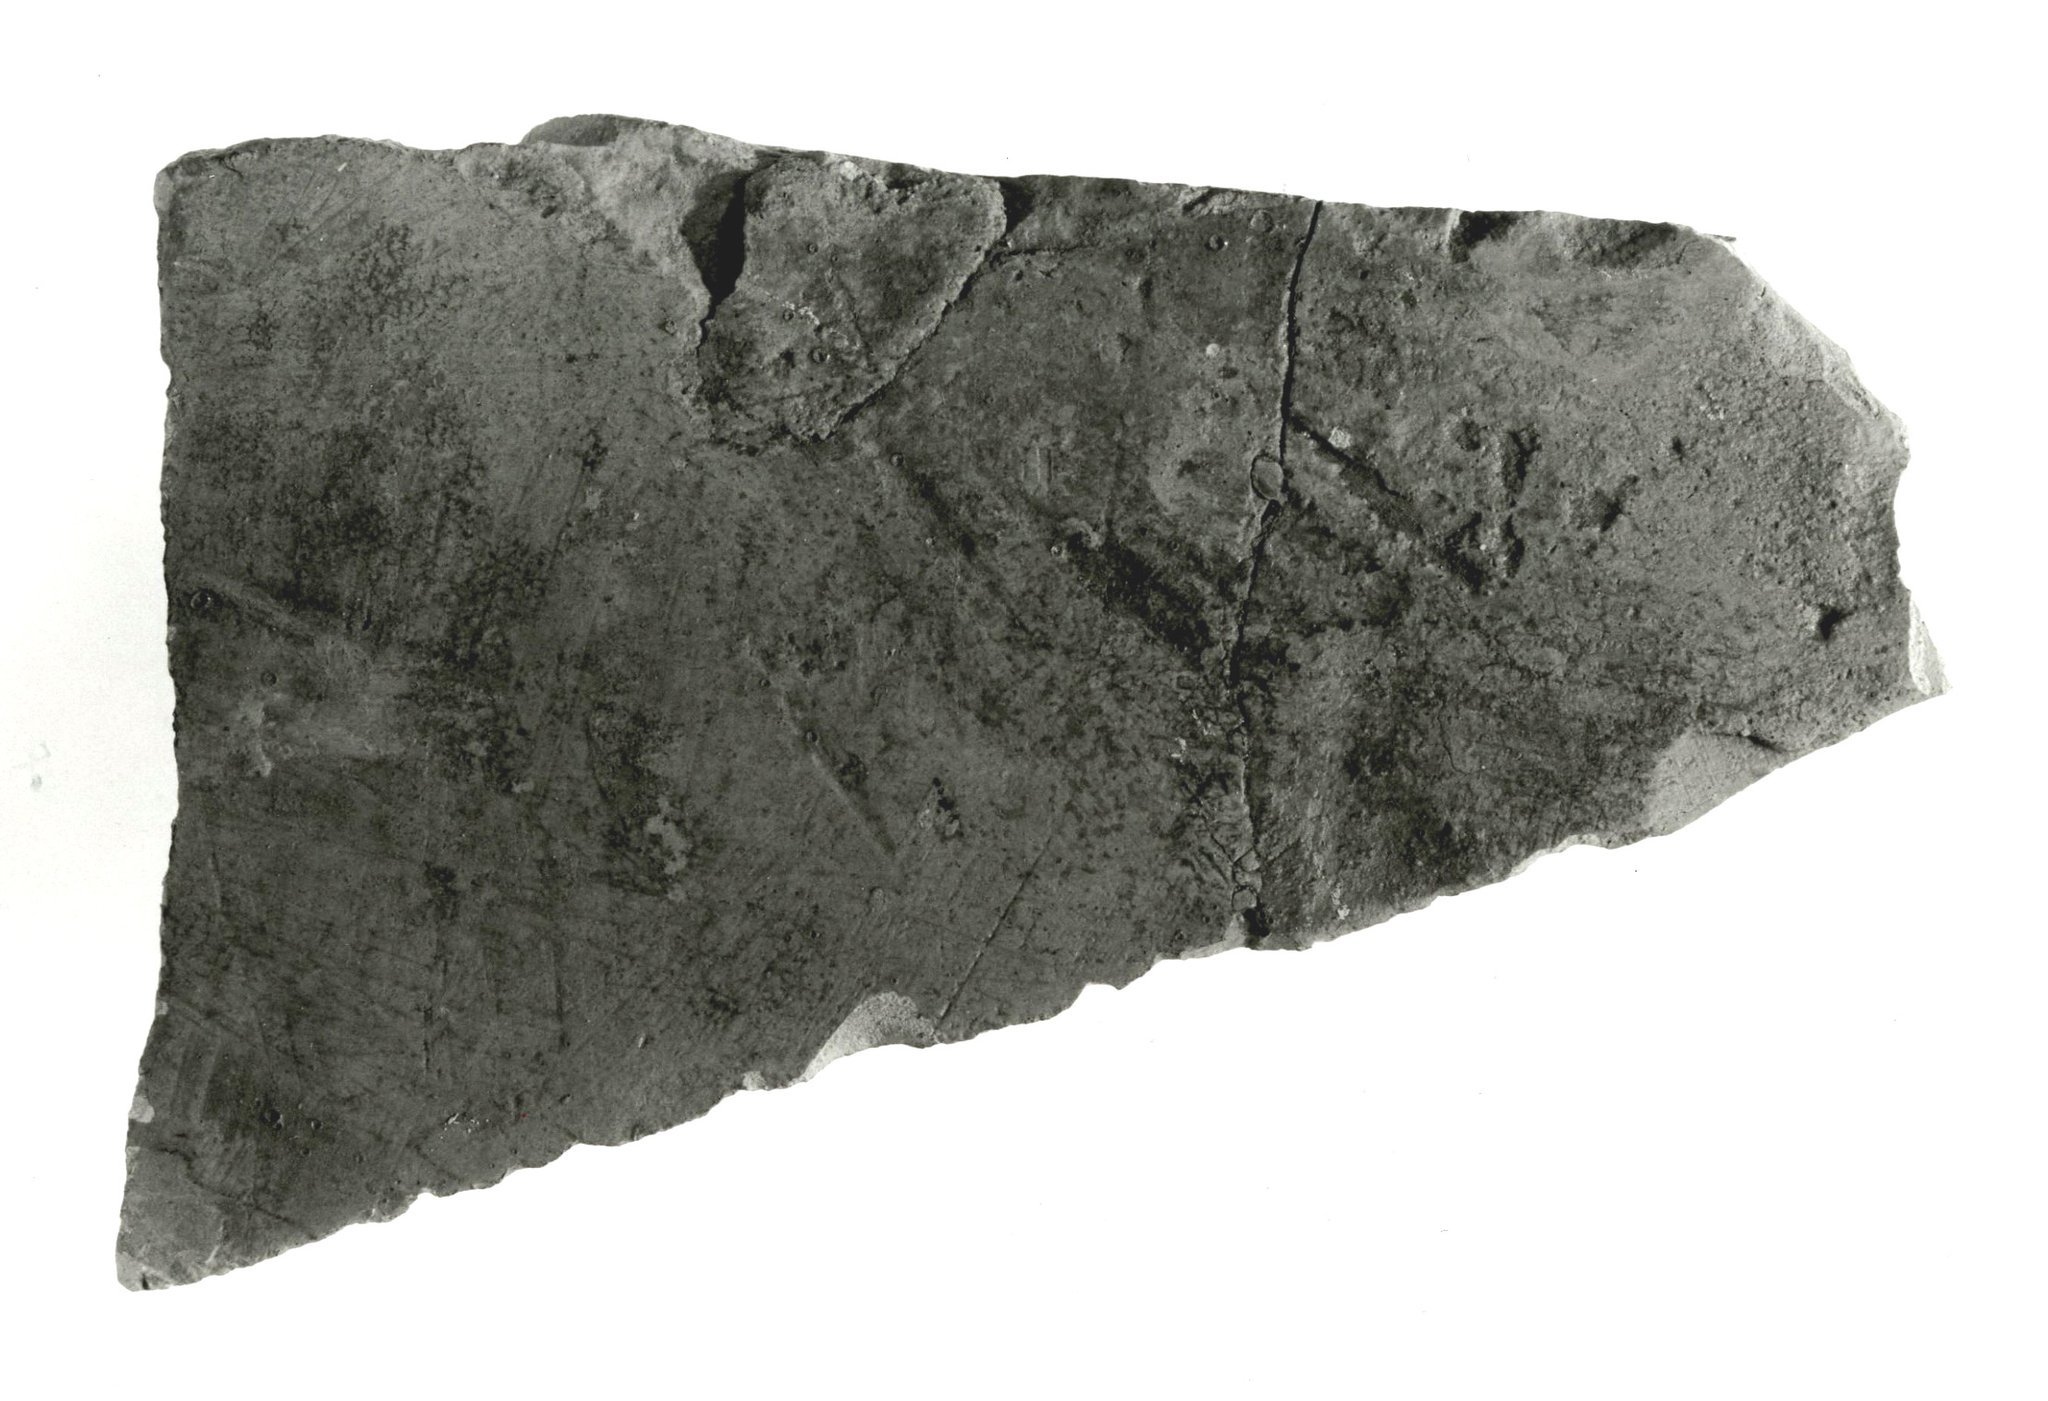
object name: relief, tomb of nespekashuty, wall casing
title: Wall casing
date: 664-610 BCE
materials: limestone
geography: egypt